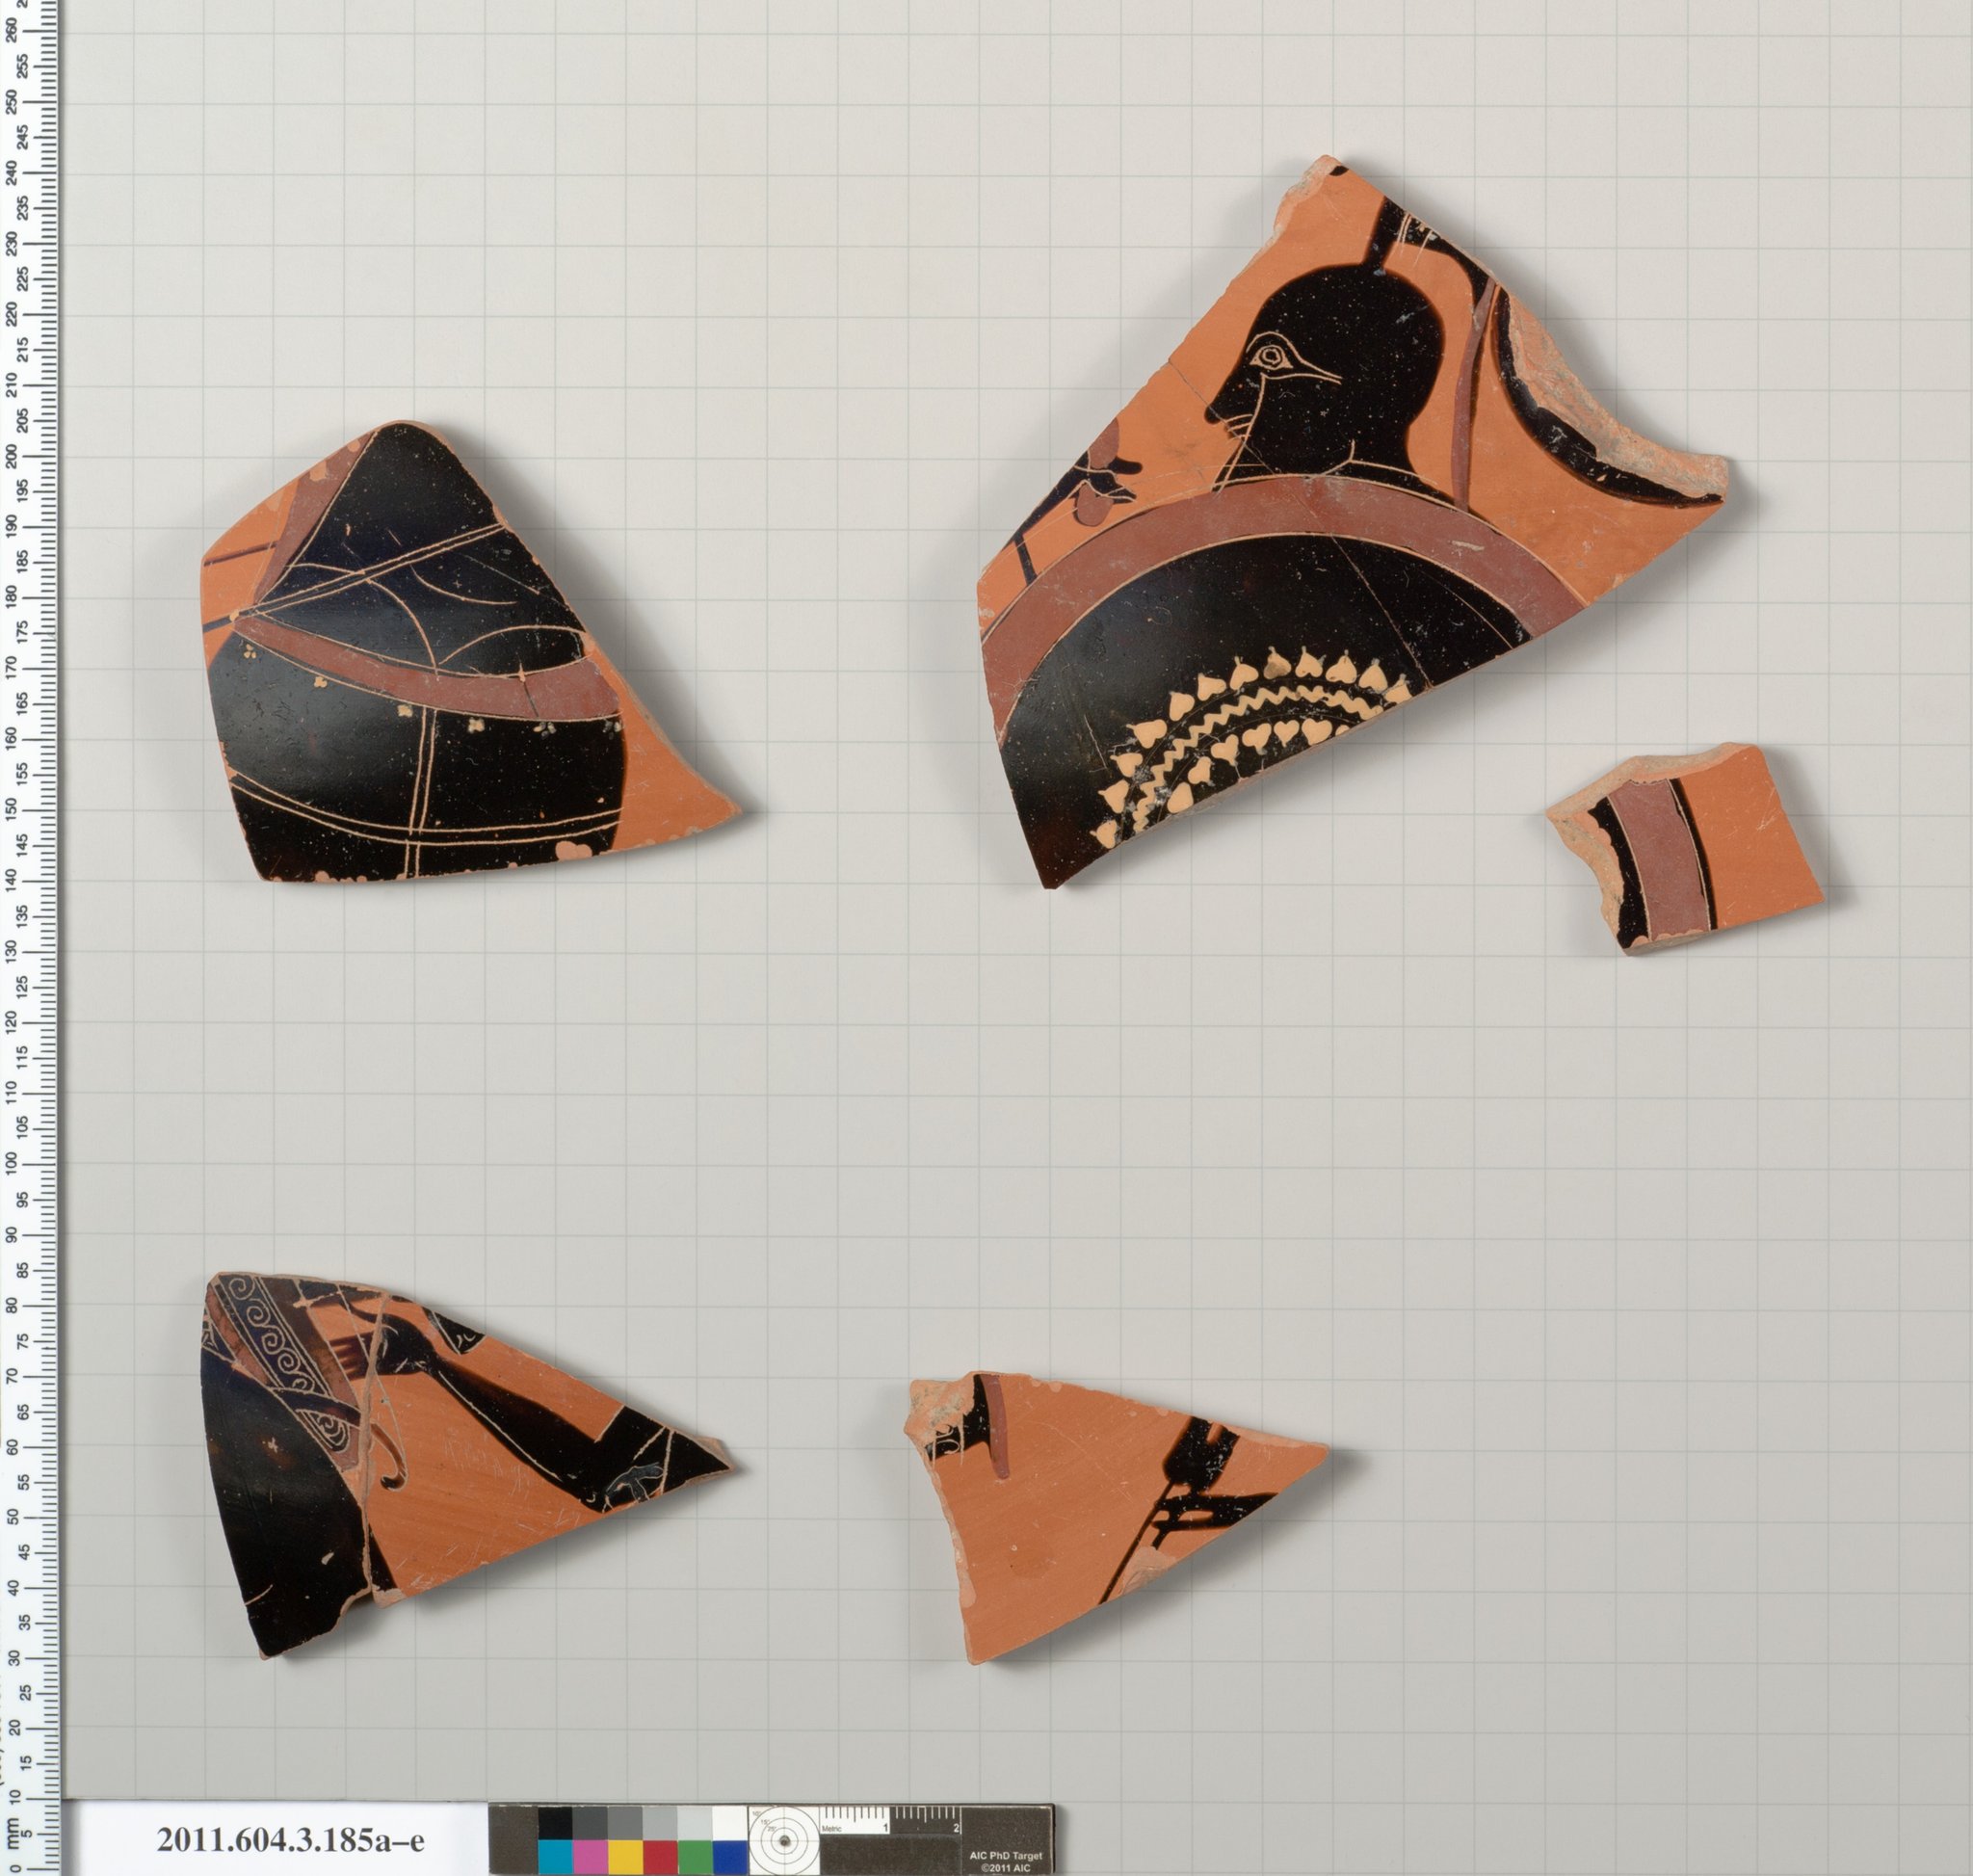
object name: amphora fragment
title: Terracotta fragments of an amphora (jar)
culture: greek, attic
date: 530-520 BCE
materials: terracotta